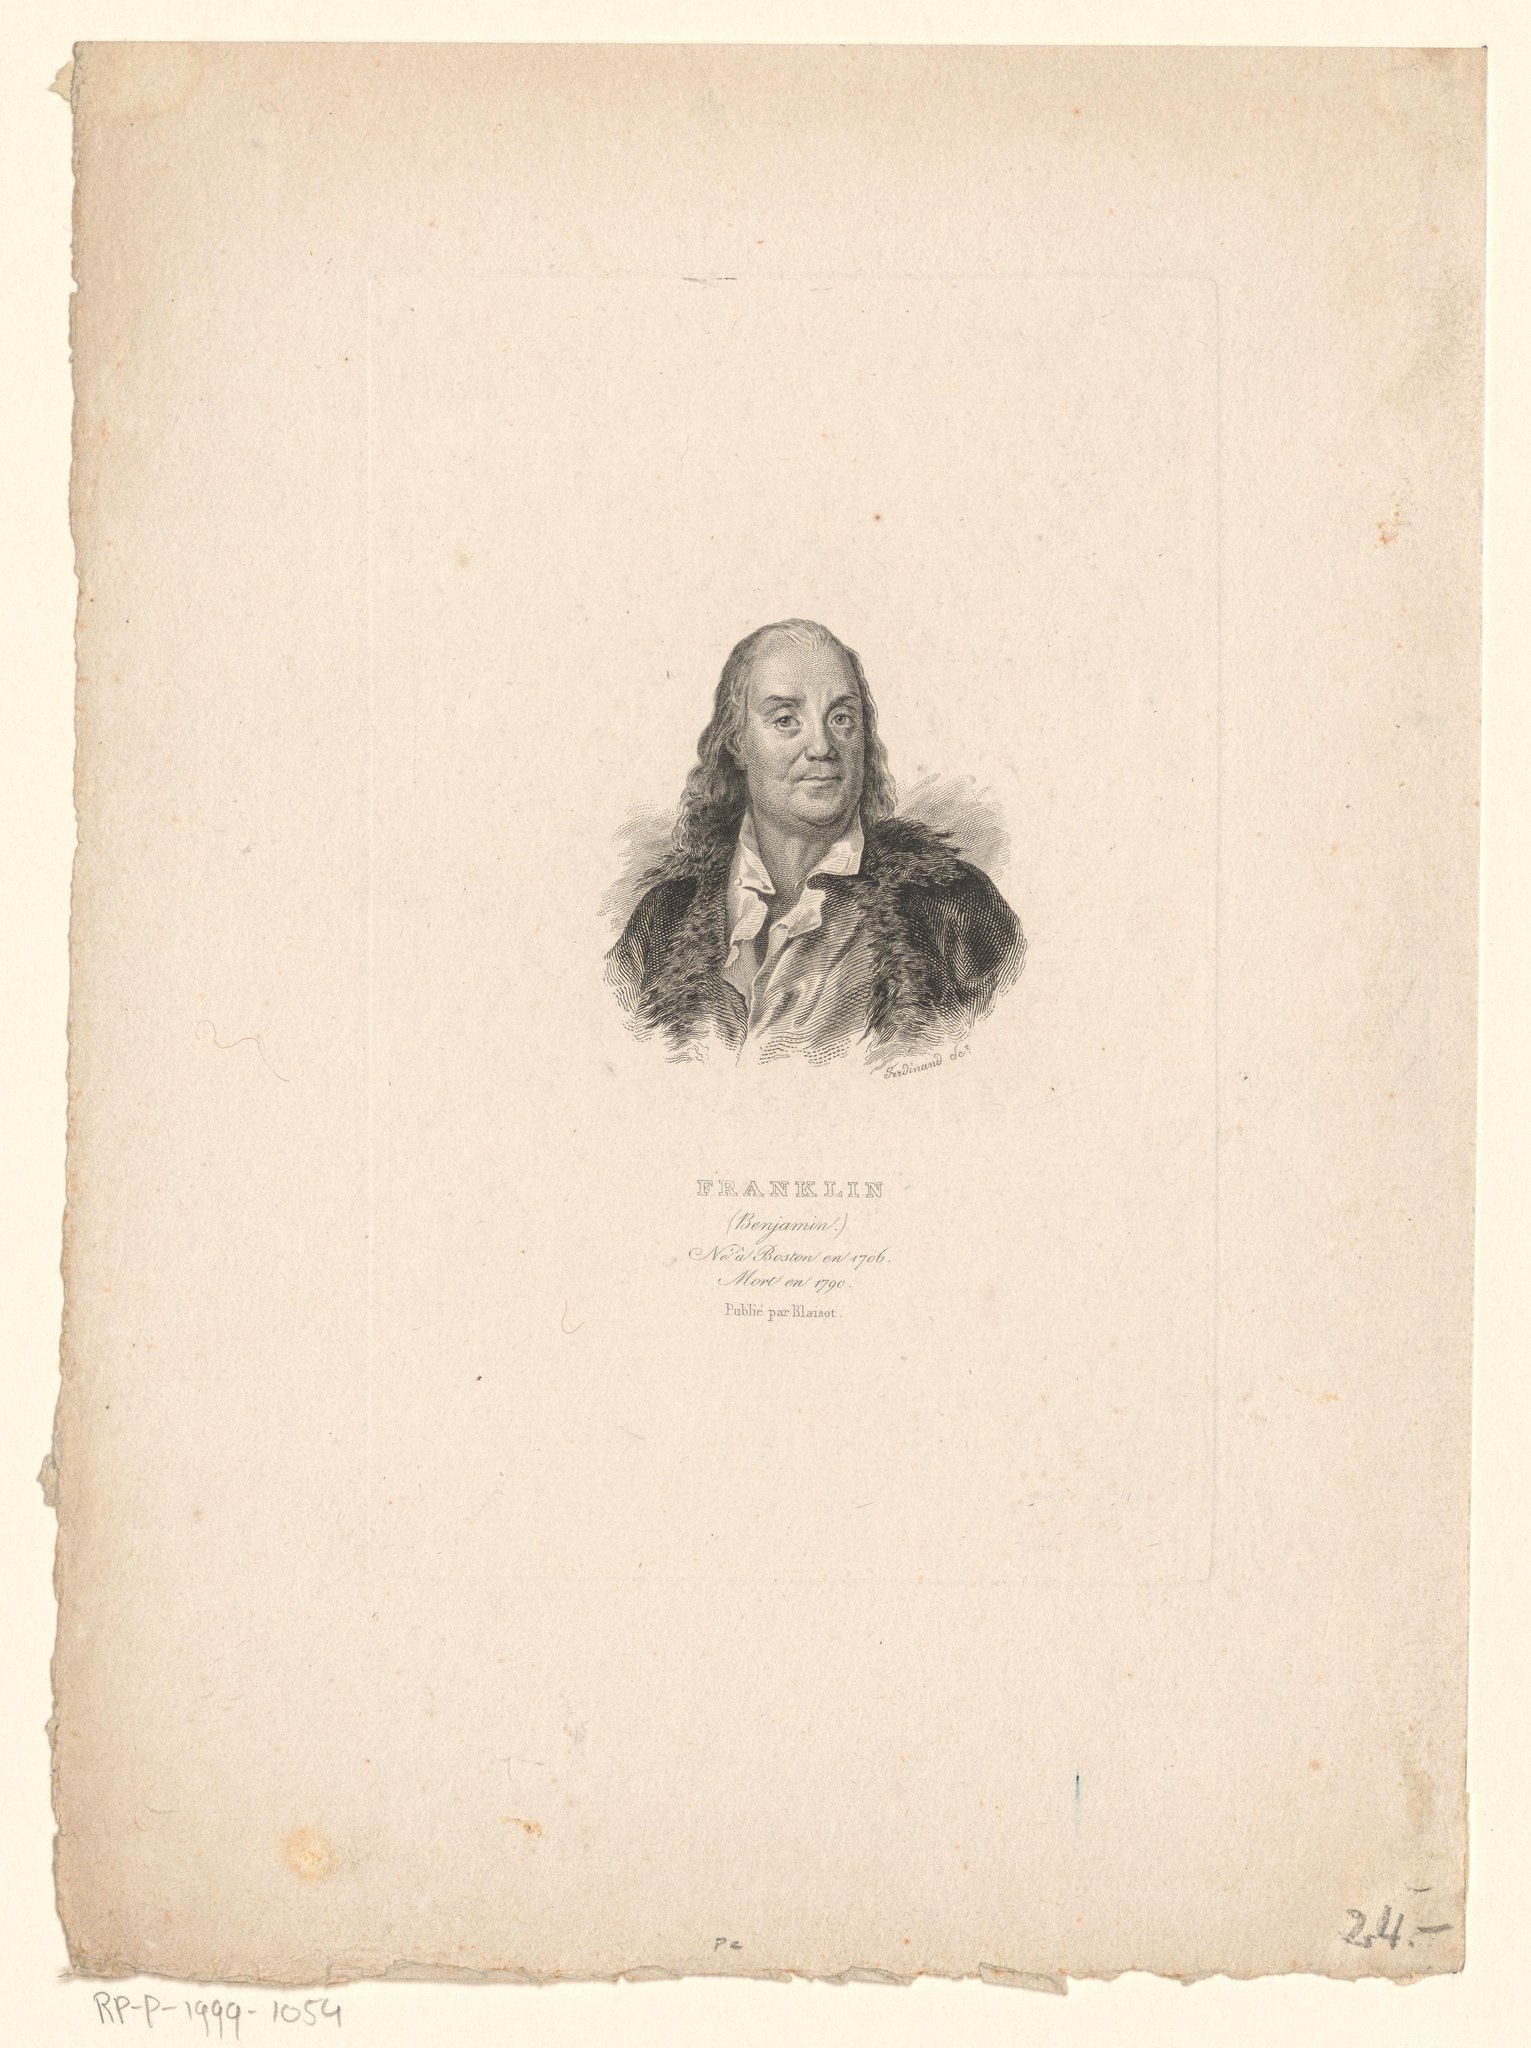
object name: print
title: Portret van Benjamin Franklin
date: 1823-1876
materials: paper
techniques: etching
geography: france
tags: physicist, historical persons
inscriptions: collector's mark: Lugt 2228, collector's mark: Lugt 2760